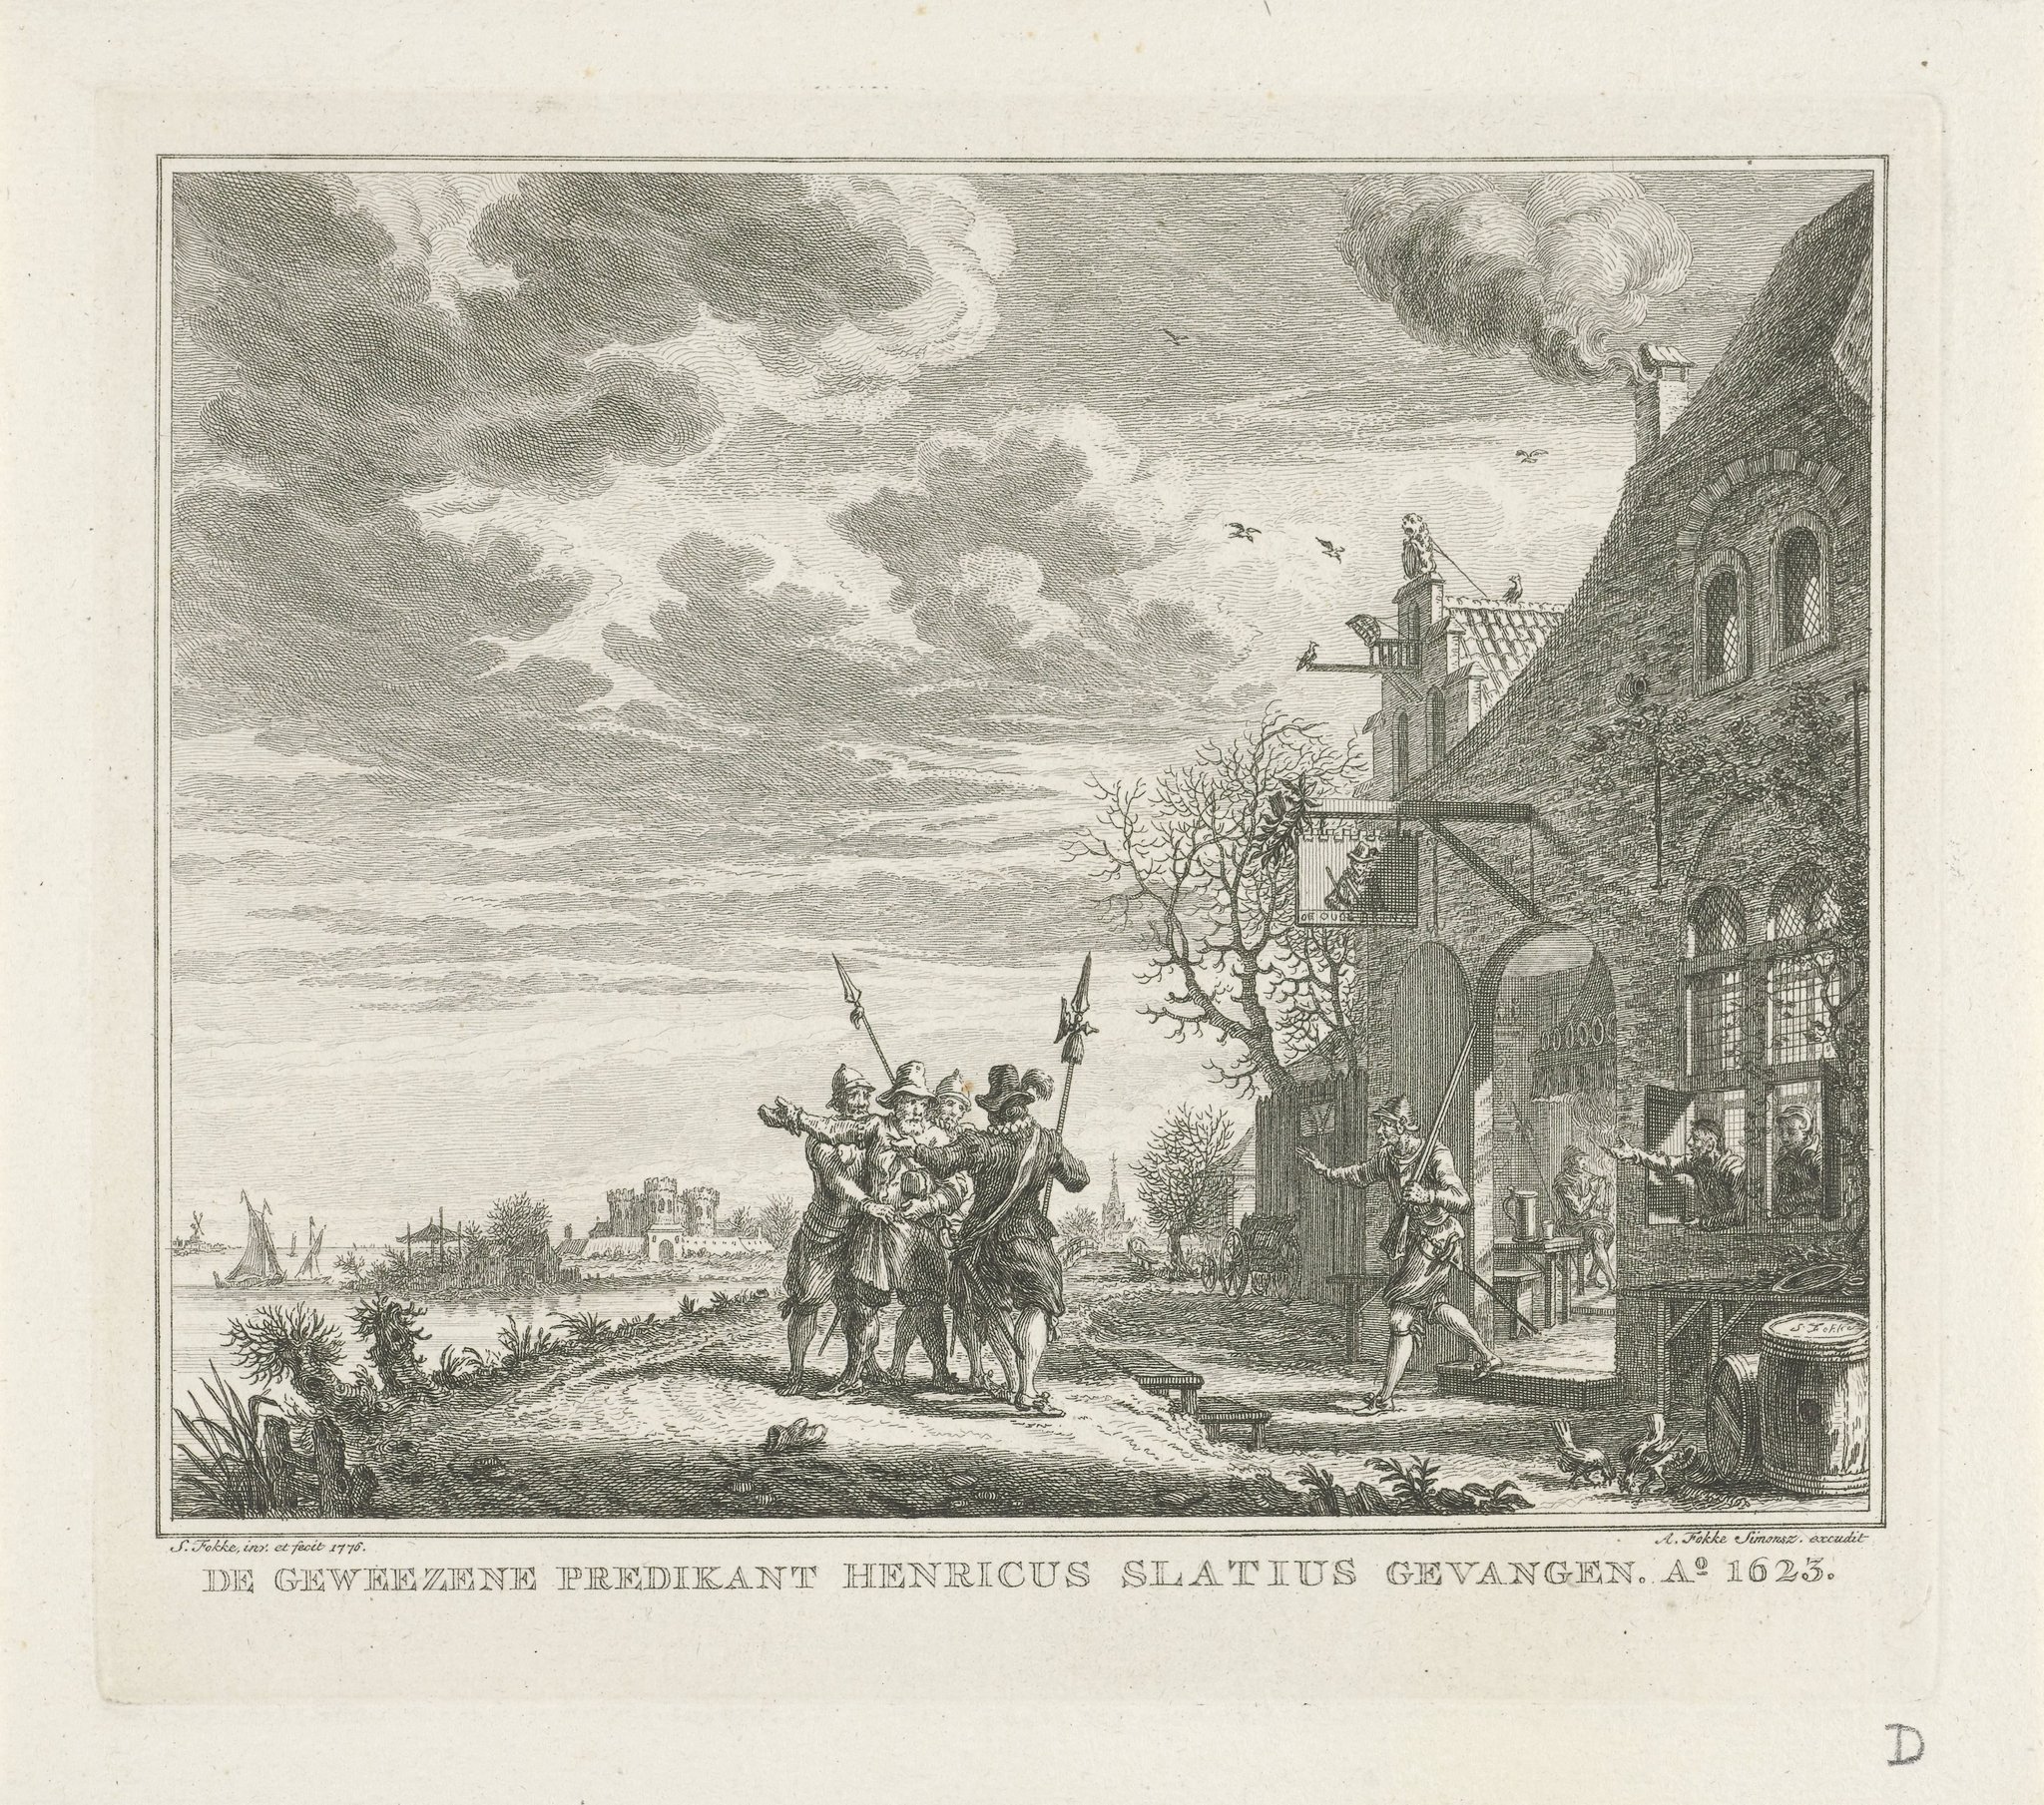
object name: print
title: De geweezene predikant Henricus Slatius gevangen. Ao 1623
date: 1776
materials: paper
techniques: etching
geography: amsterdam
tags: imprisonment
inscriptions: collector's mark: Lugt 2228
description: Voor een herberg wordt de voormalige predikant Henricus Slatius gevangen genomen.